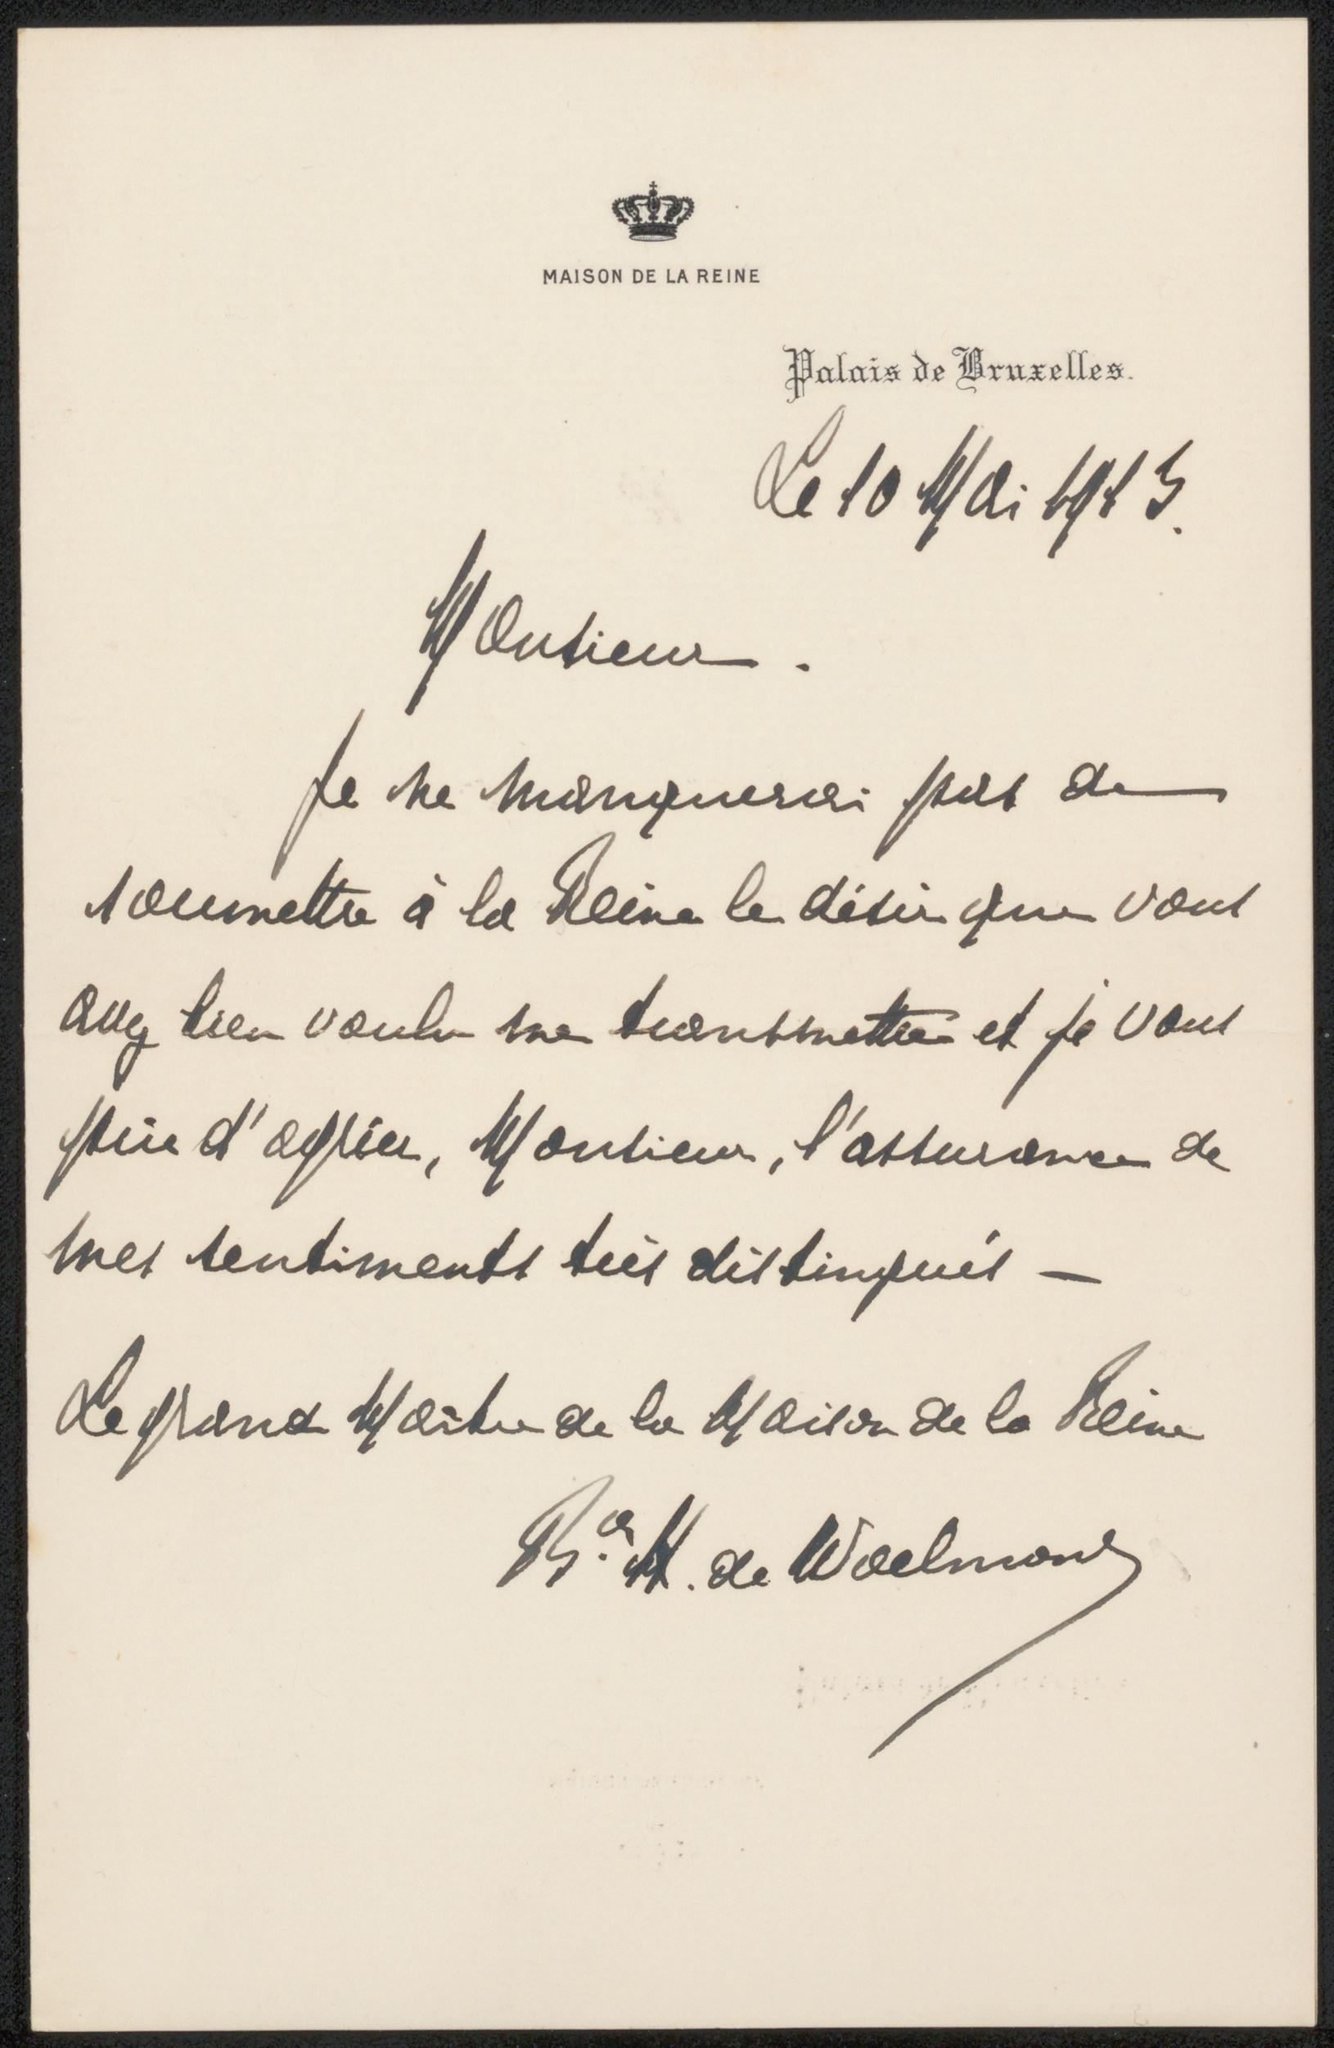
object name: letter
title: Brief aan Antonie Lodewijk Koster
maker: Anonymous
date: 1913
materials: ink, paper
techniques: pen, printing, writing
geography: brussels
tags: haarlem, painter, print maker, anton l. koster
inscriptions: address: ‘MAISON DE LA REINE/ Palais de Bruxelles.’, collector's mark: ‘RPK’